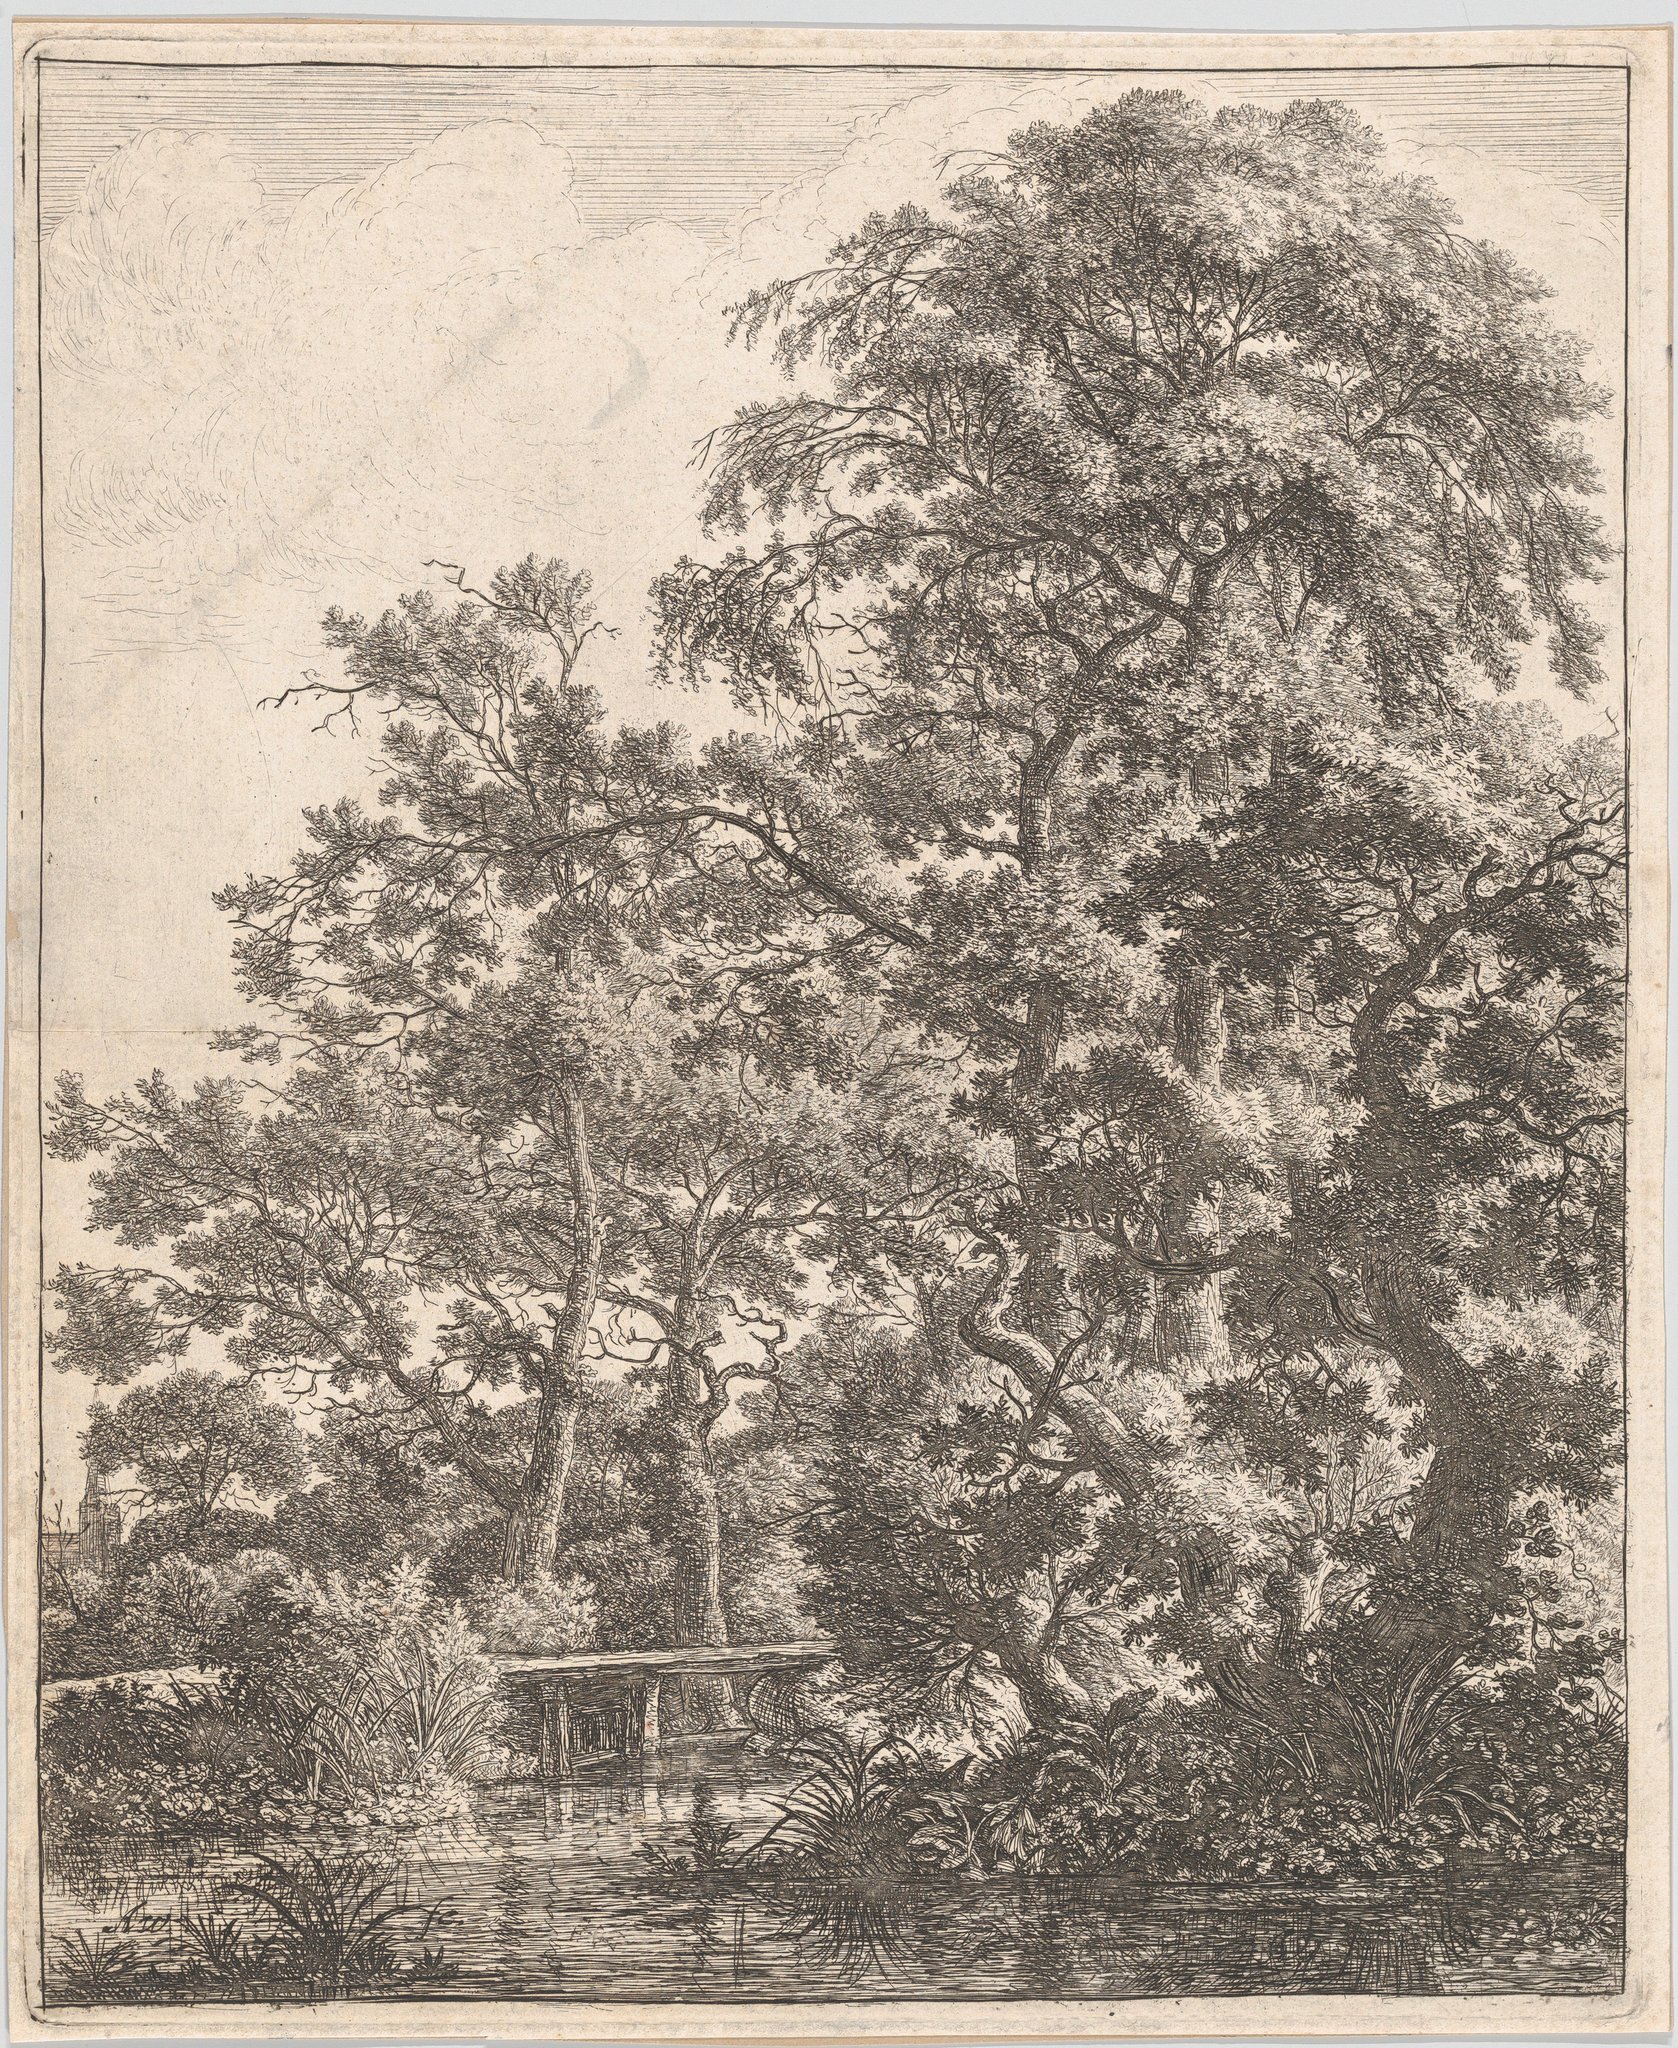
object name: print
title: A Small Bridge over a Stream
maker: anthonie waterloo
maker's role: artist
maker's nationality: dutch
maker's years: 1609-1690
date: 1601-1700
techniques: etching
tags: bridges,trees